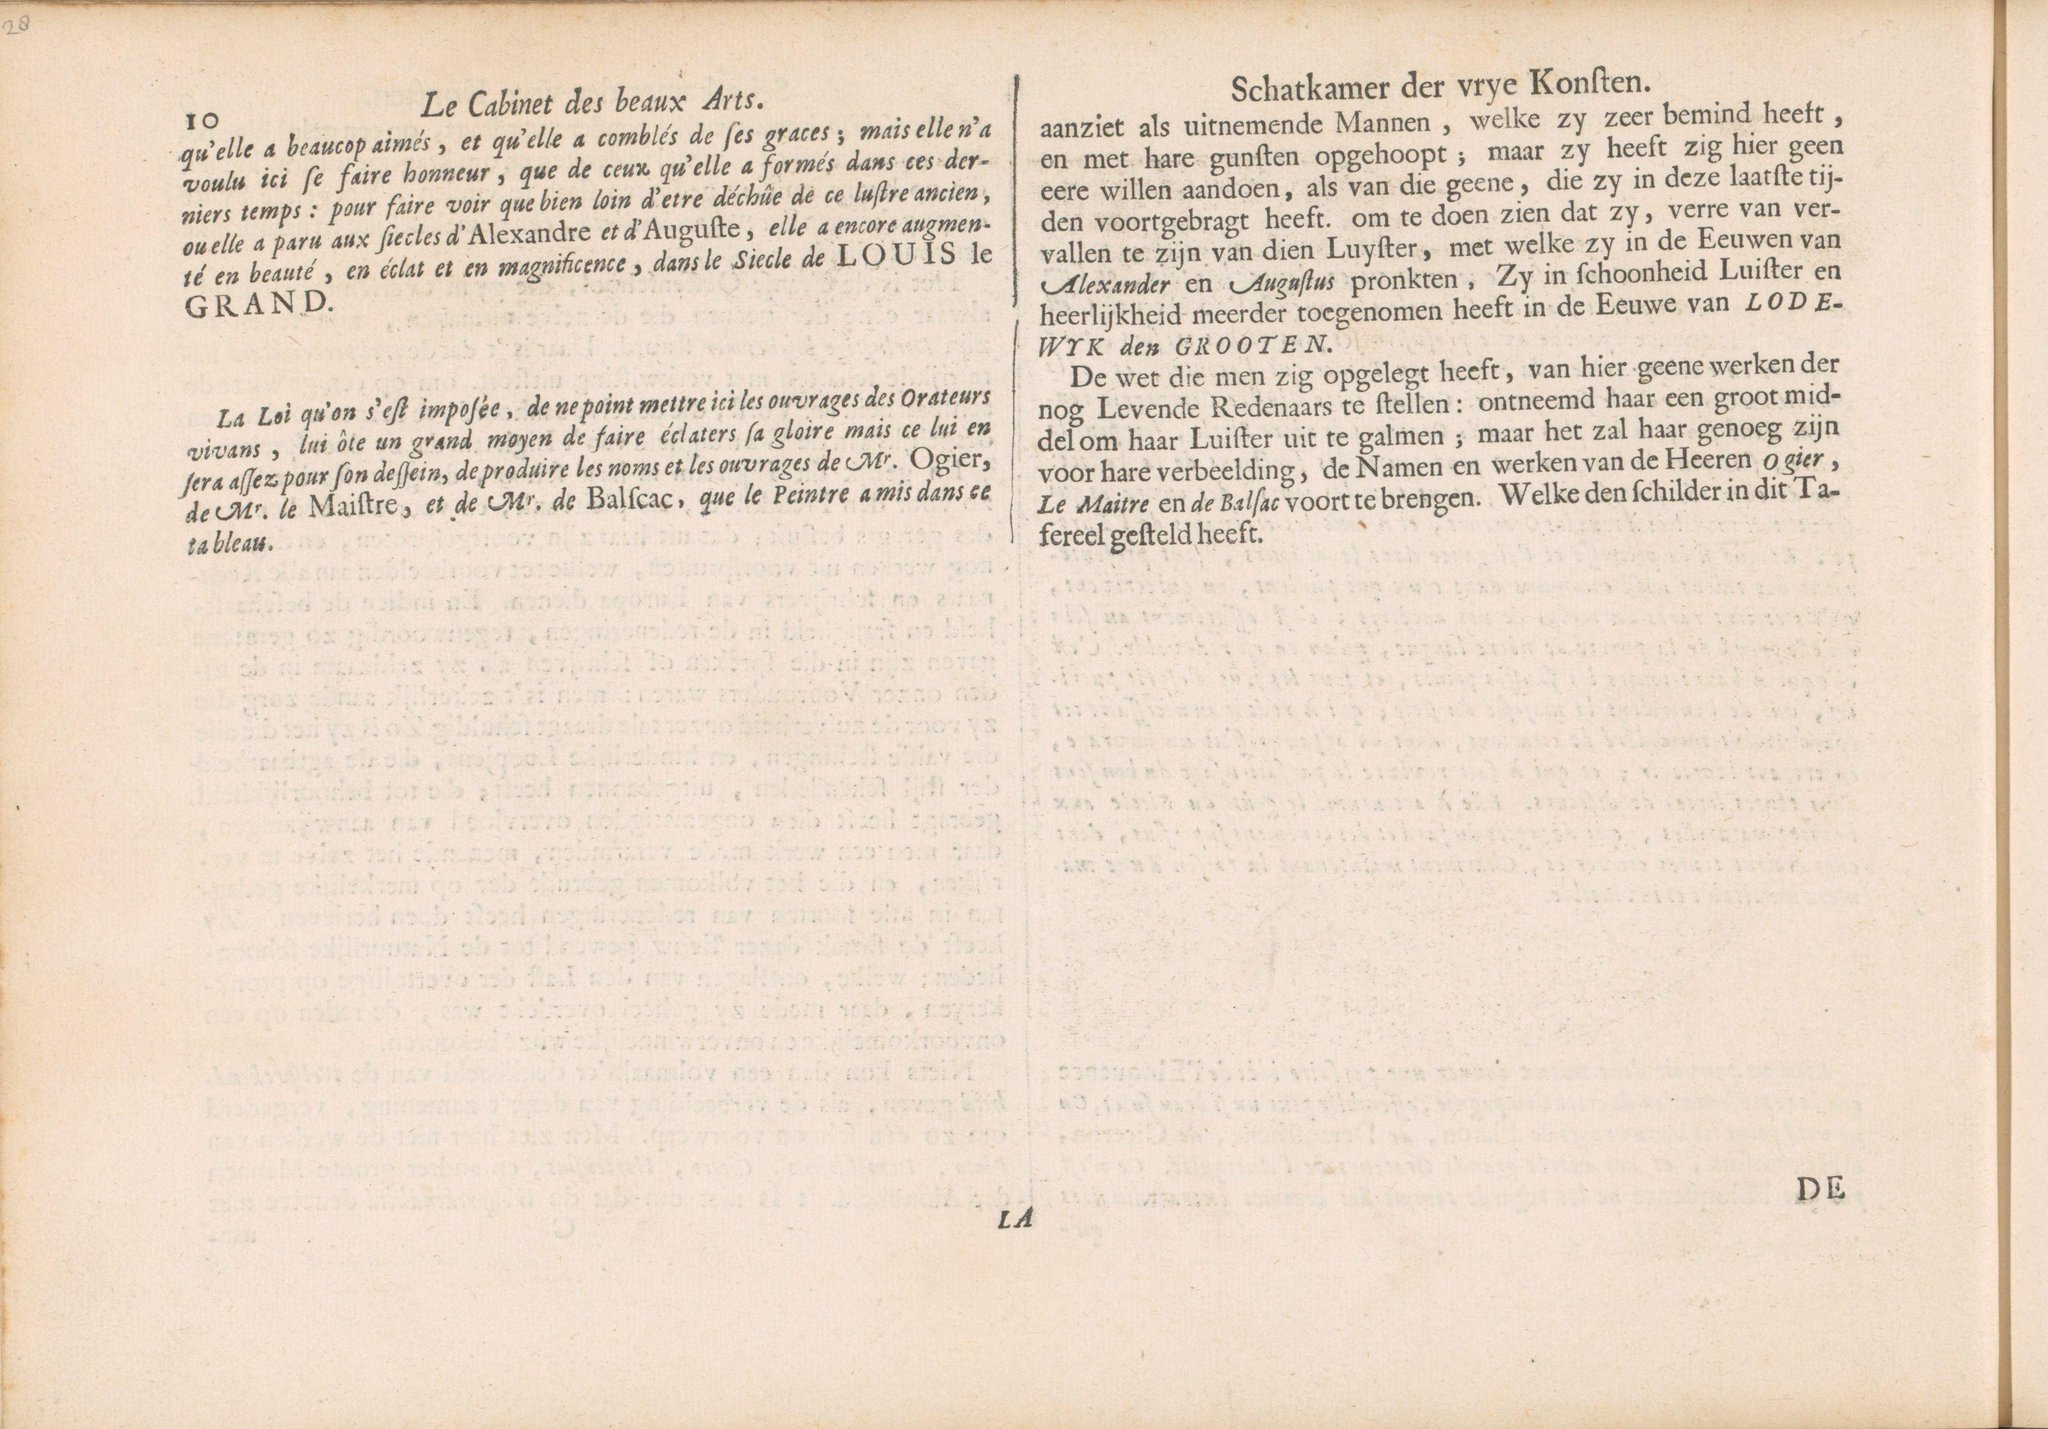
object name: text sheet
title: Tekstblad over de Welsprekendheid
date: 1693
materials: paper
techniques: letterpress printing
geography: amsterdam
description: Verklaring van de prent met de voorstelling van de personificatie van Welsprekendheid in het Frans en het Nederlands, pagina 10. Tekstblad maakt deel uit van een album.